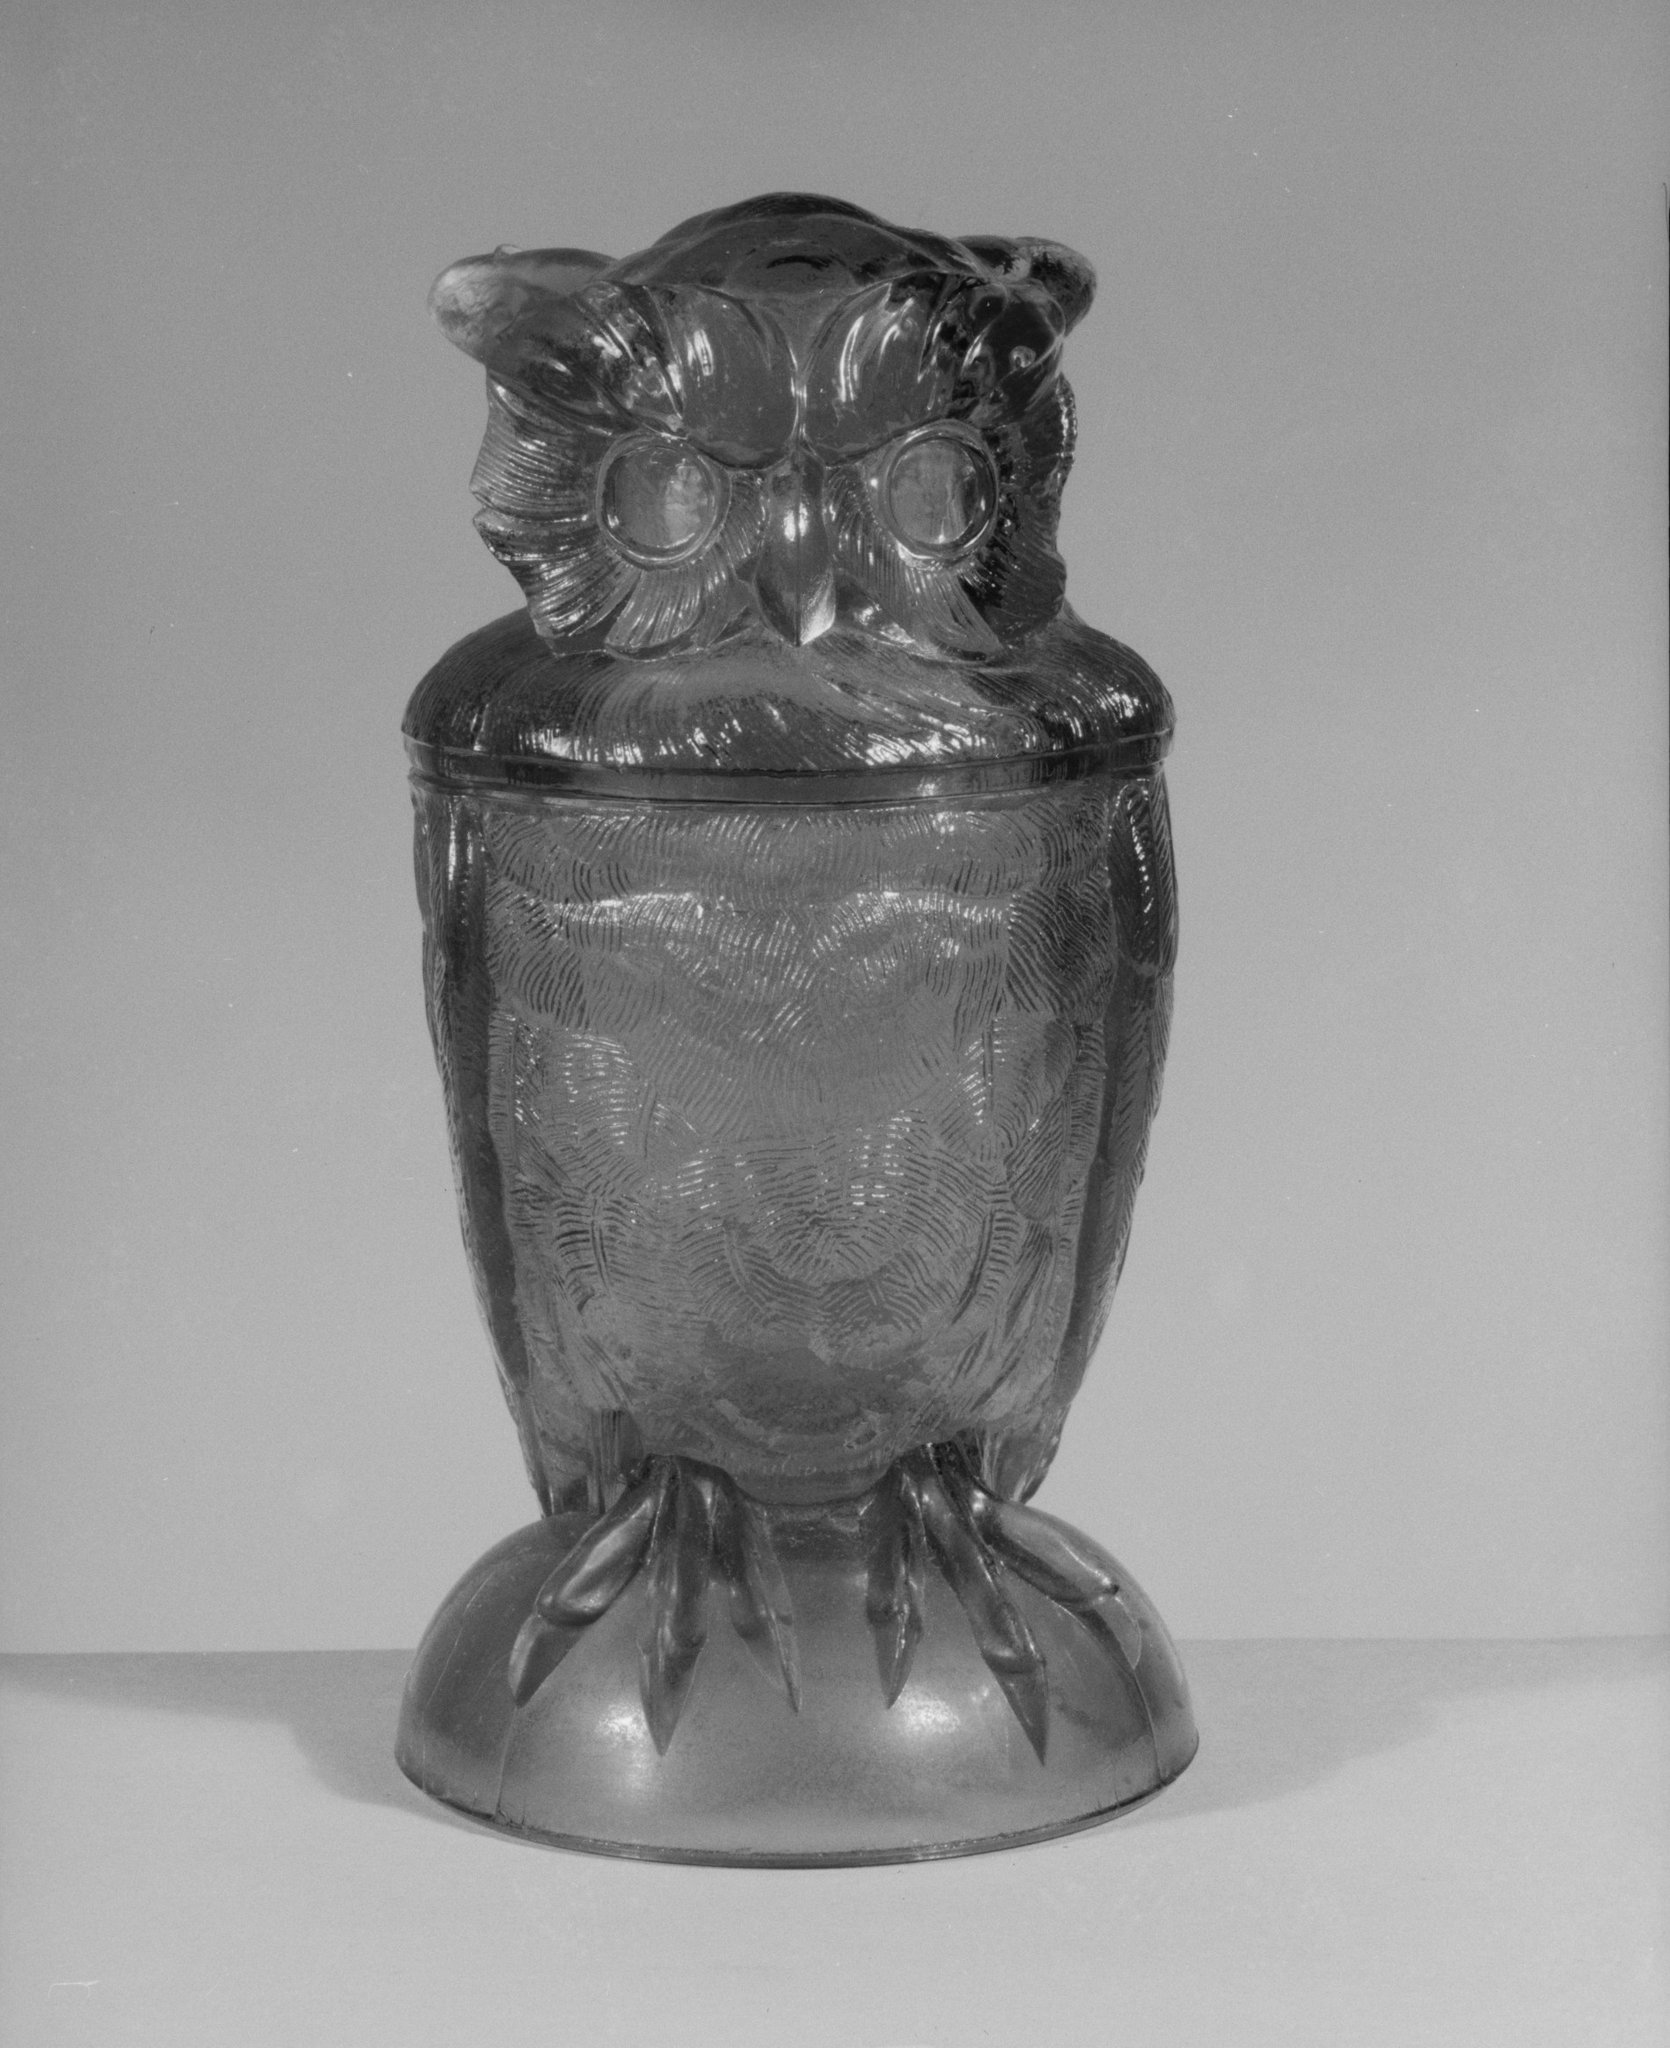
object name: jar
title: Covered Owl Jar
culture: american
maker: atterbury and company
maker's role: maker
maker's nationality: american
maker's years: 1864-1893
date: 1880-1890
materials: glass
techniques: pressed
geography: united states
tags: owls